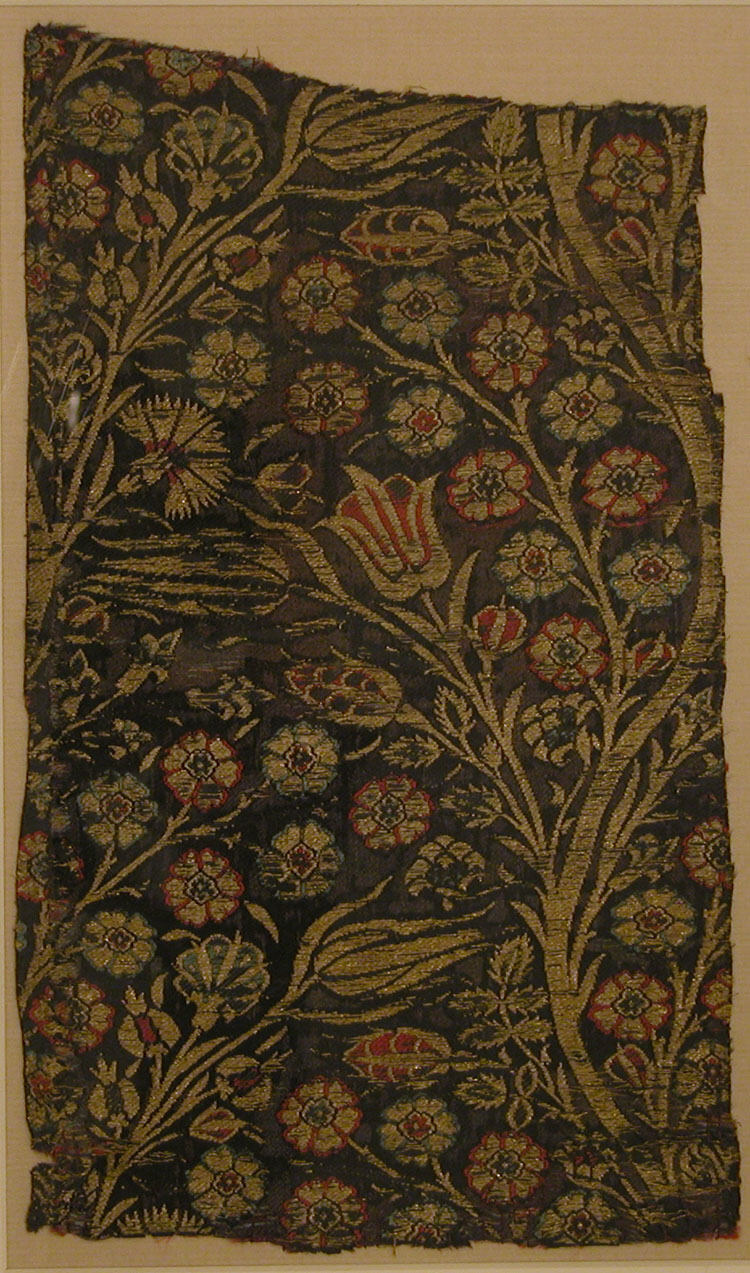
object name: textile fragment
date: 1601-1650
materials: metal thread, silk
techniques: lampas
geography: turkey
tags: flowers